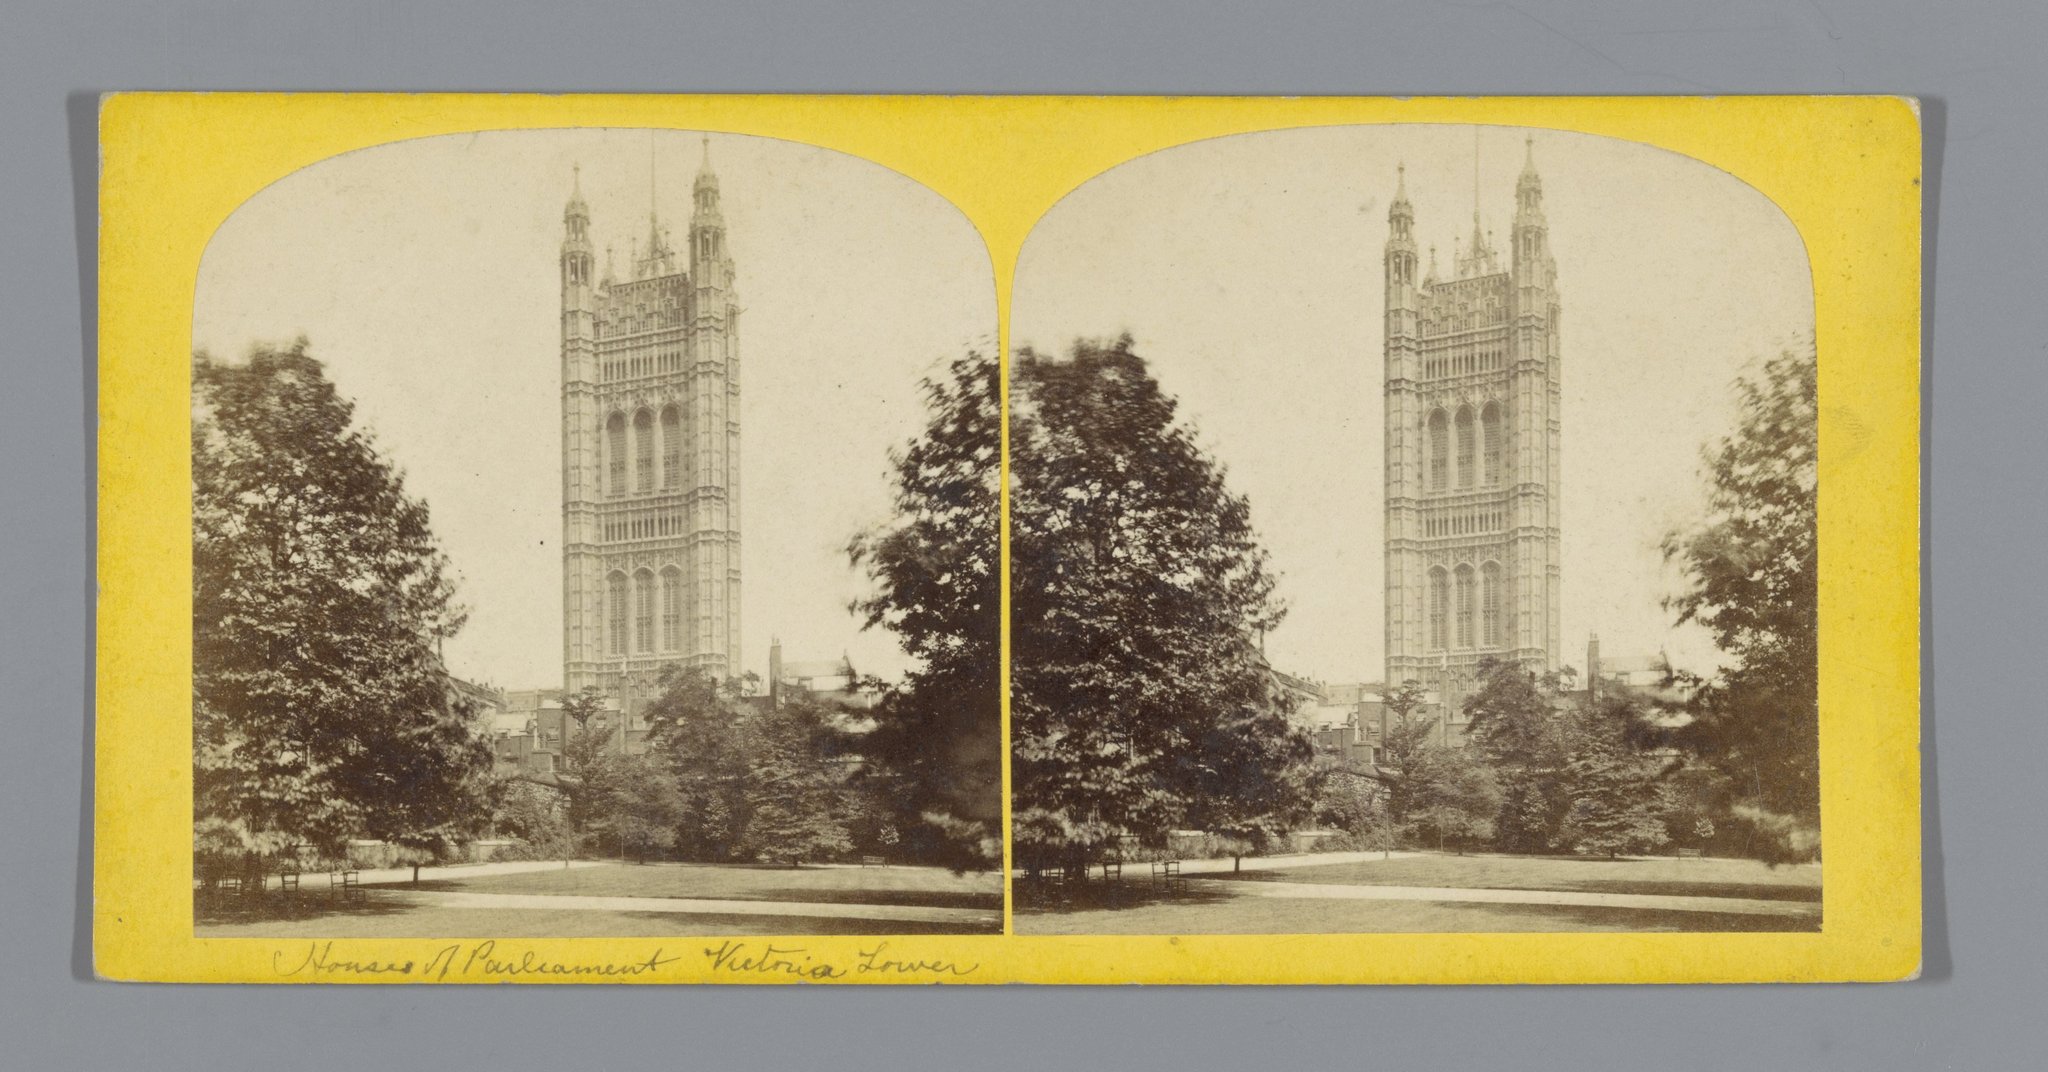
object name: stereograph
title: Gezicht op de Victoria Tower van de House of Parliament in Londen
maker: Anonymous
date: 1860-1880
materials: cardboard, photographic support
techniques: albumen print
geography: london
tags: tower, clock tower ~ monumental adornment, lower house, parliament, chamber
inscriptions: number: ‘124.’, name: ‘Hearn & Co Opticians Montreal’